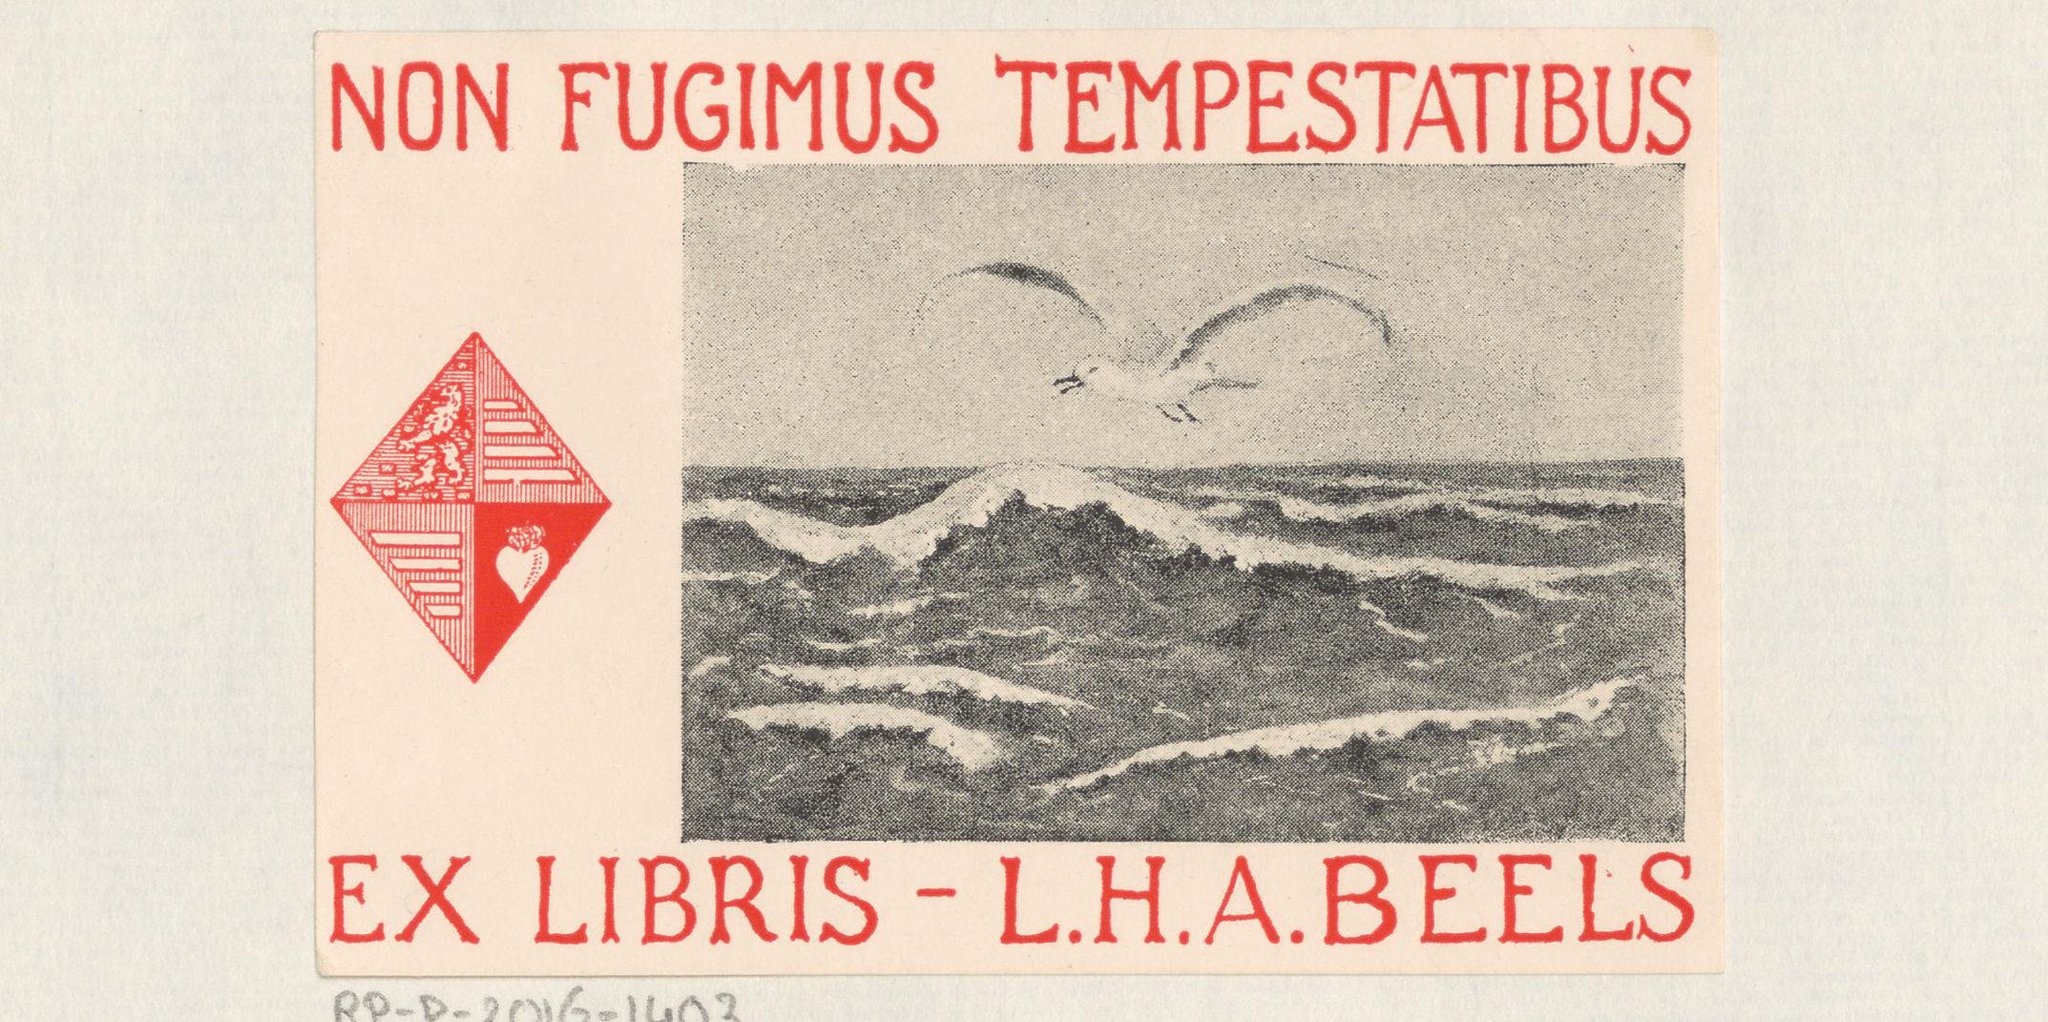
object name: bookplate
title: Ex libris van L.H.A. Beels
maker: Anonymous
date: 1919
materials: paper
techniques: printing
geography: netherlands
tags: shore-birds and wading-birds: gull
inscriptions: inscription: ‘2584 / 4’